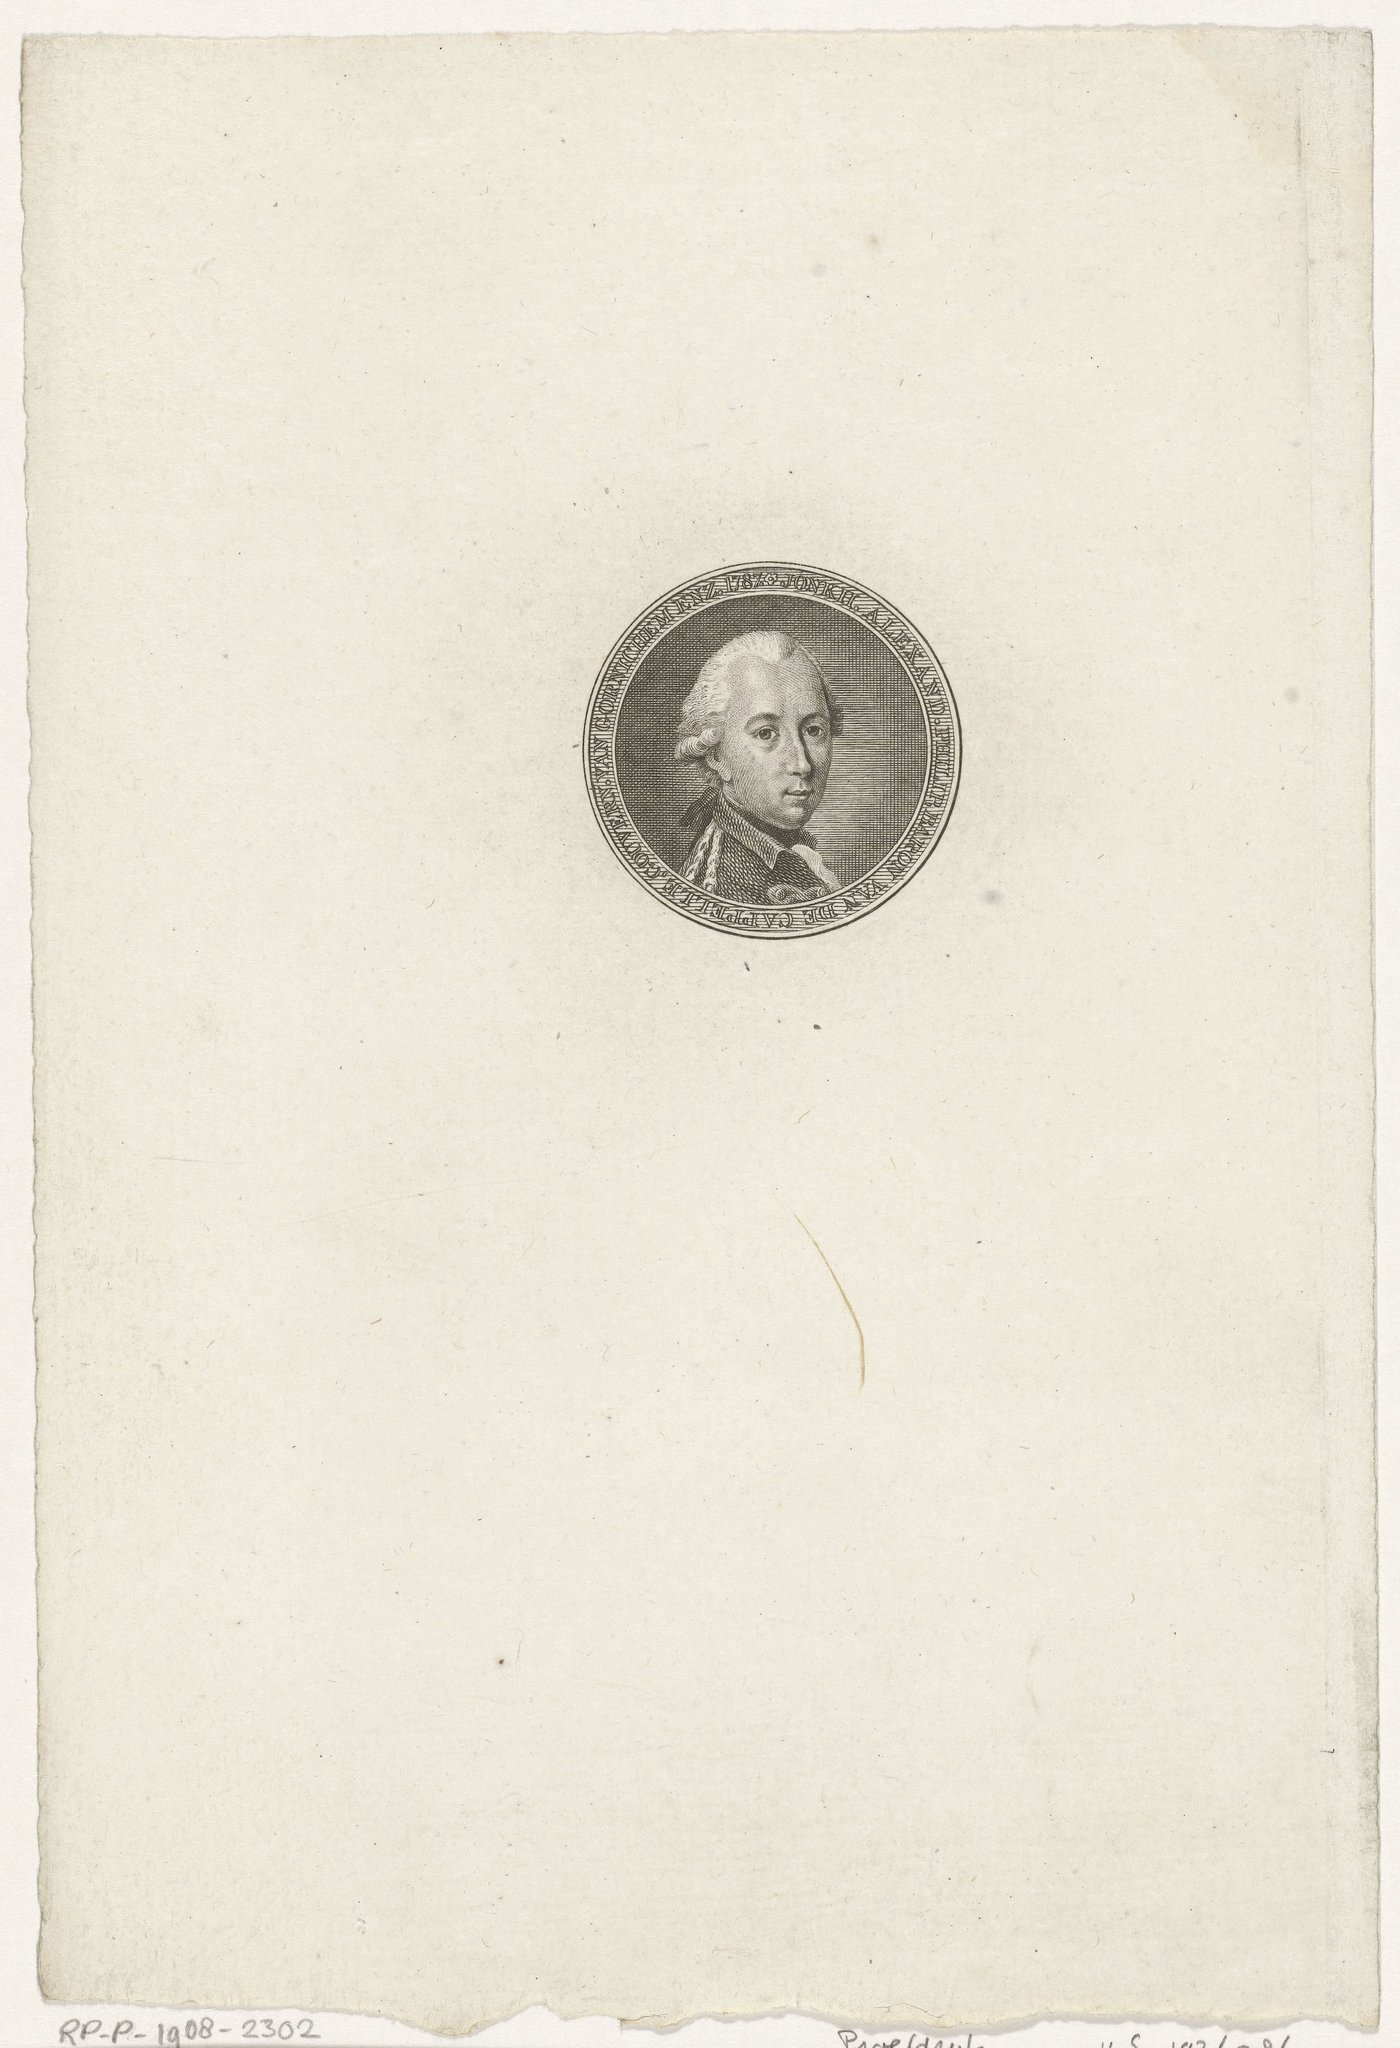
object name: print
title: Portret van Alexander Philip van der Capellen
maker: abraham jacobsz. hulk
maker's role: print maker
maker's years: 1751-1817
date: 1787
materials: paper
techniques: engraving, etching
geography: paris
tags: utrecht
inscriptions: collector's mark: Lugt 2228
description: De plaat van deze prent werd door Jacobus Wijsman aangepast en hergebruikt in zijn eigen serie patriottenportretten.